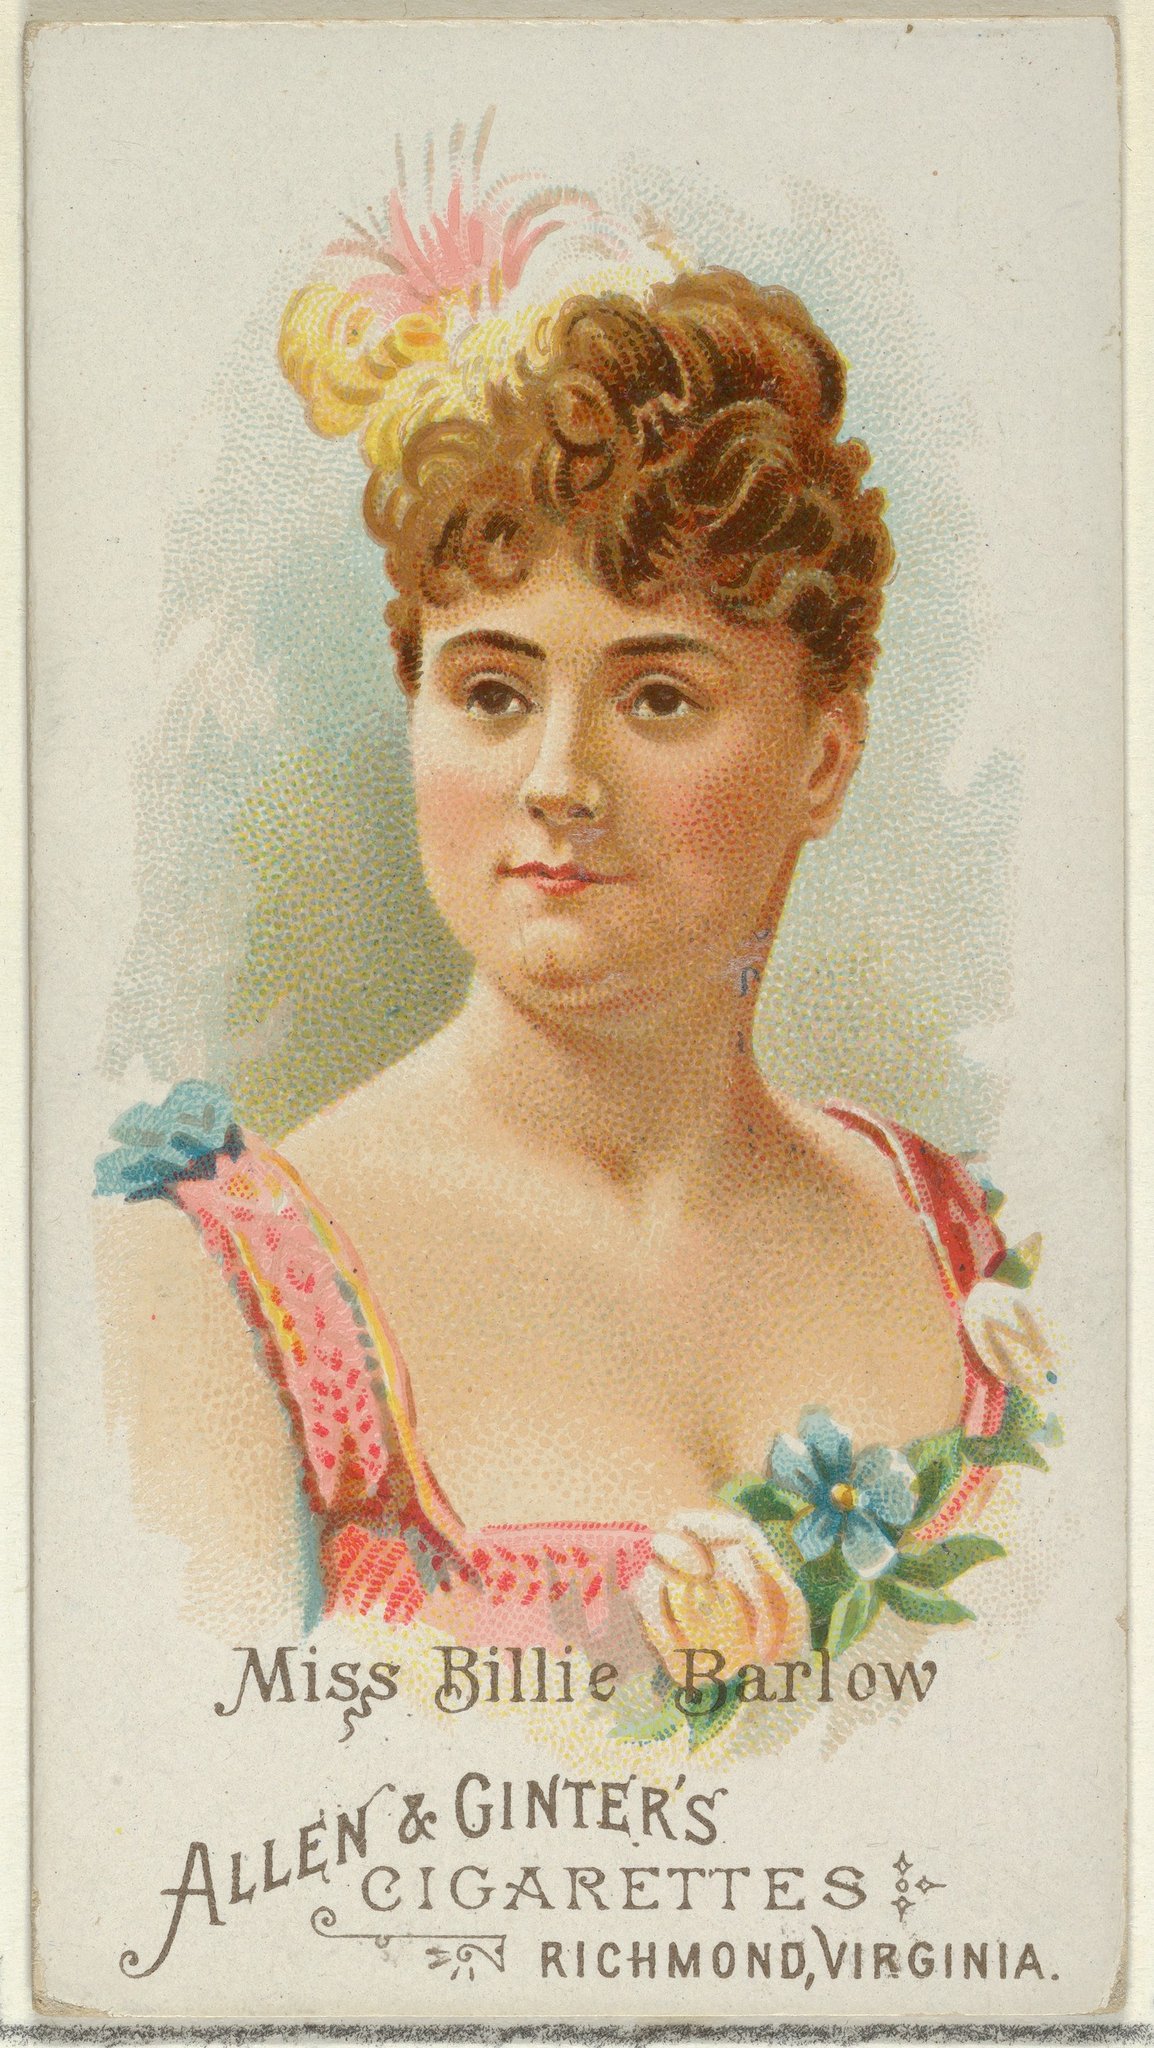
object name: print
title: Miss Billie Barlow, from World's Beauties, Series 1 (N26) for Allen & Ginter Cigarettes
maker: allen & ginter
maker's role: publisher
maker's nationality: american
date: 1888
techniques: color lithograph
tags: women